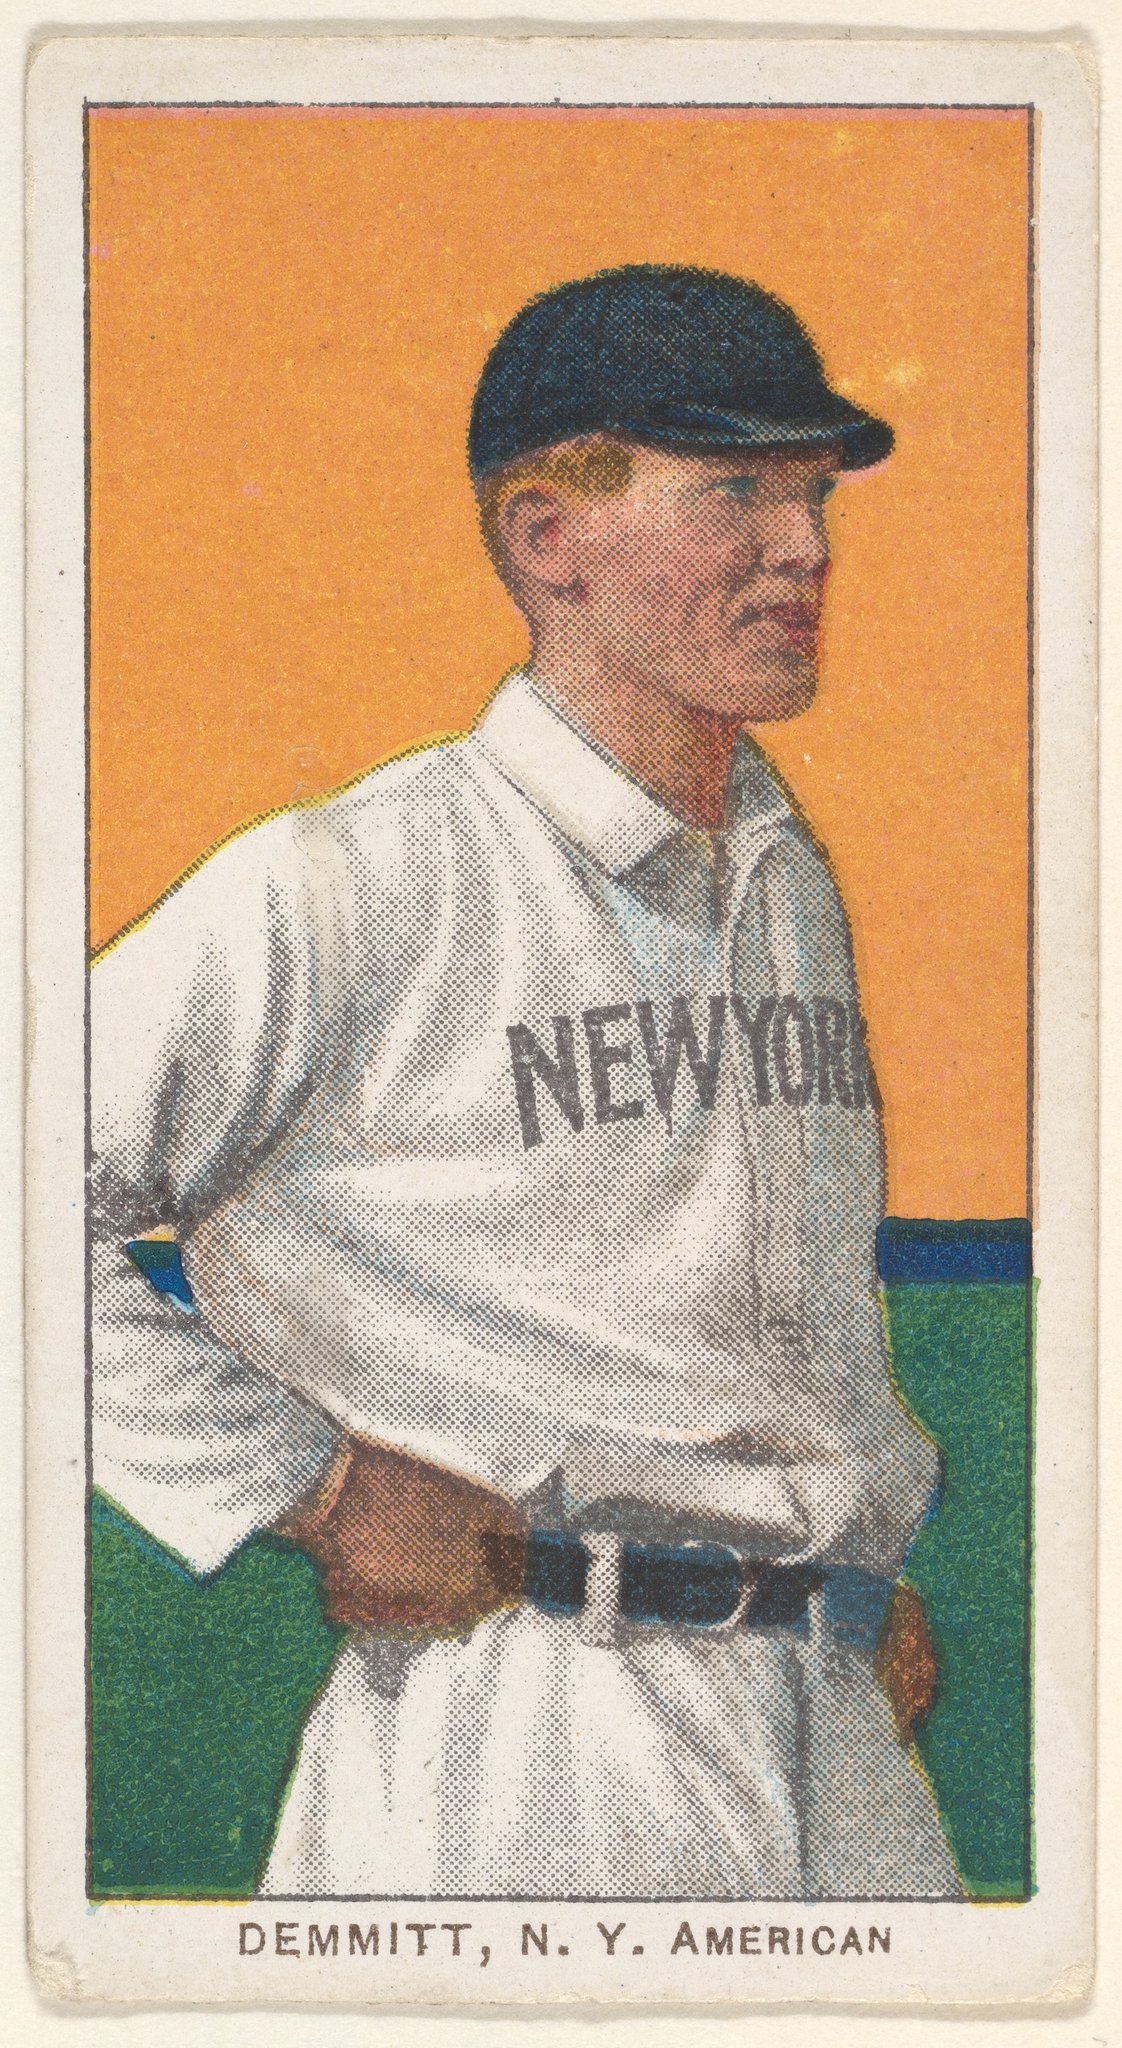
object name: baseball card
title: Demmitt, New York, American League, from the White Border series (T206) for the American Tobacco Company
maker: american tobacco company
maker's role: publisher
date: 1909-1911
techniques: lithography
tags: men,baseball,athletes